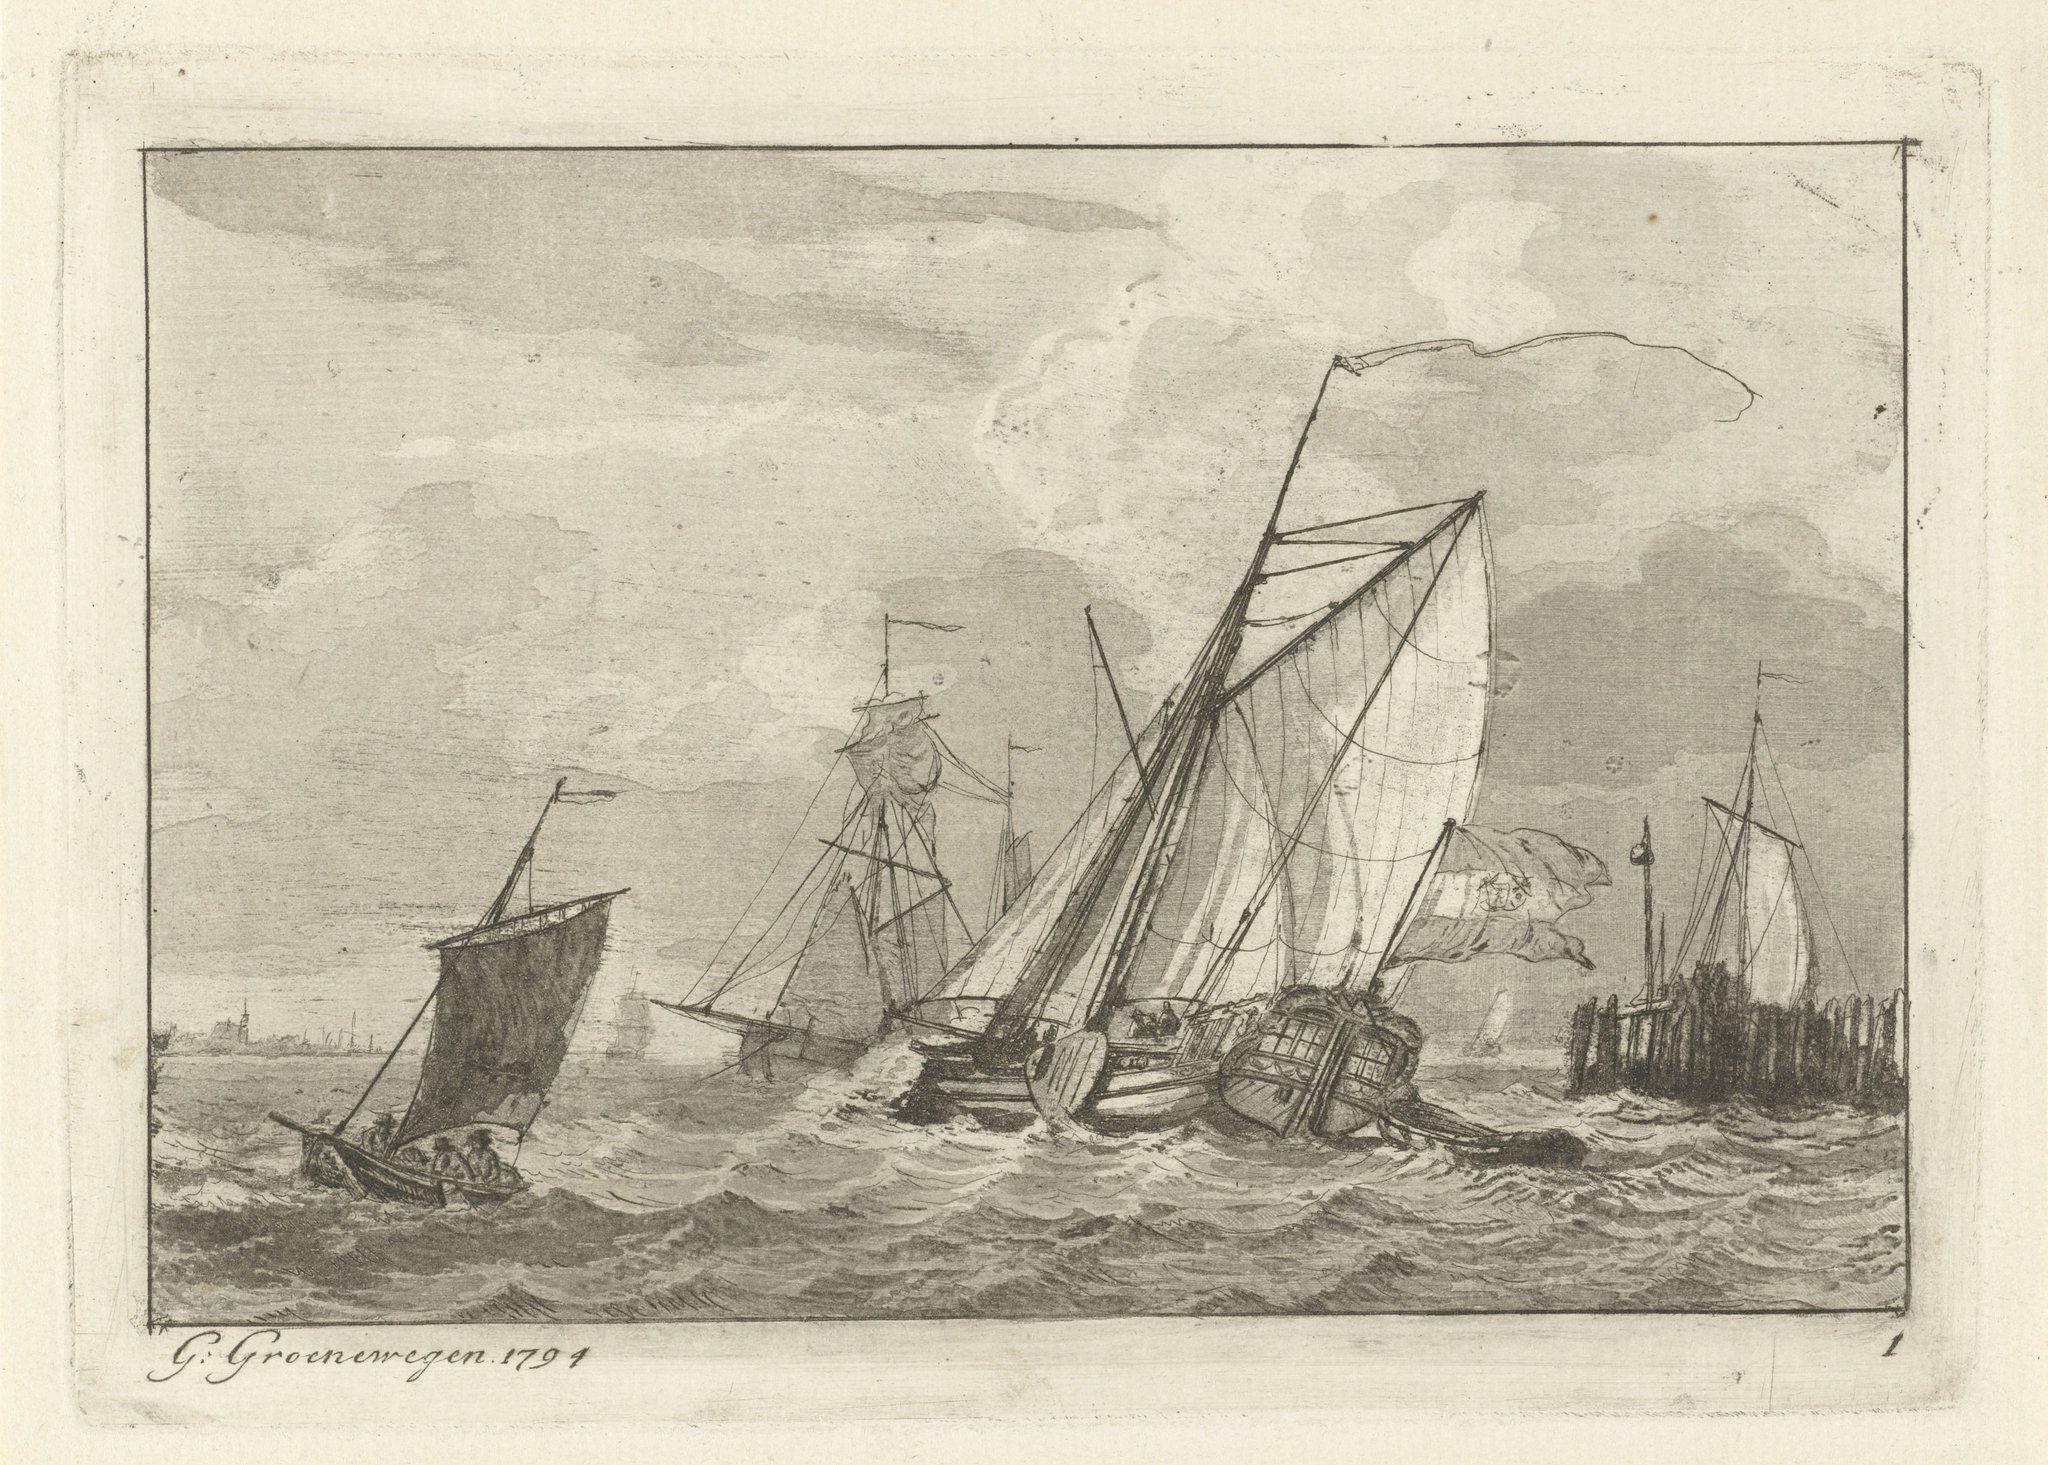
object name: print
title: Verschillende schepen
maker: gerrit groenewegen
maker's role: draughtsman, print maker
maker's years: 1754-1826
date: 1791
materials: paper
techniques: aquatint, etching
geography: rotterdam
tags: ships (in general) - cc - more than one ship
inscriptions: collector's mark: Lugt 2228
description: Diverse schepen op ruig water in de buurt van een steiger. Links op de achtergrond de contouren van een dorp. Deze prent maakt deel uit van een serie van zes prenten met verschillende schepen.